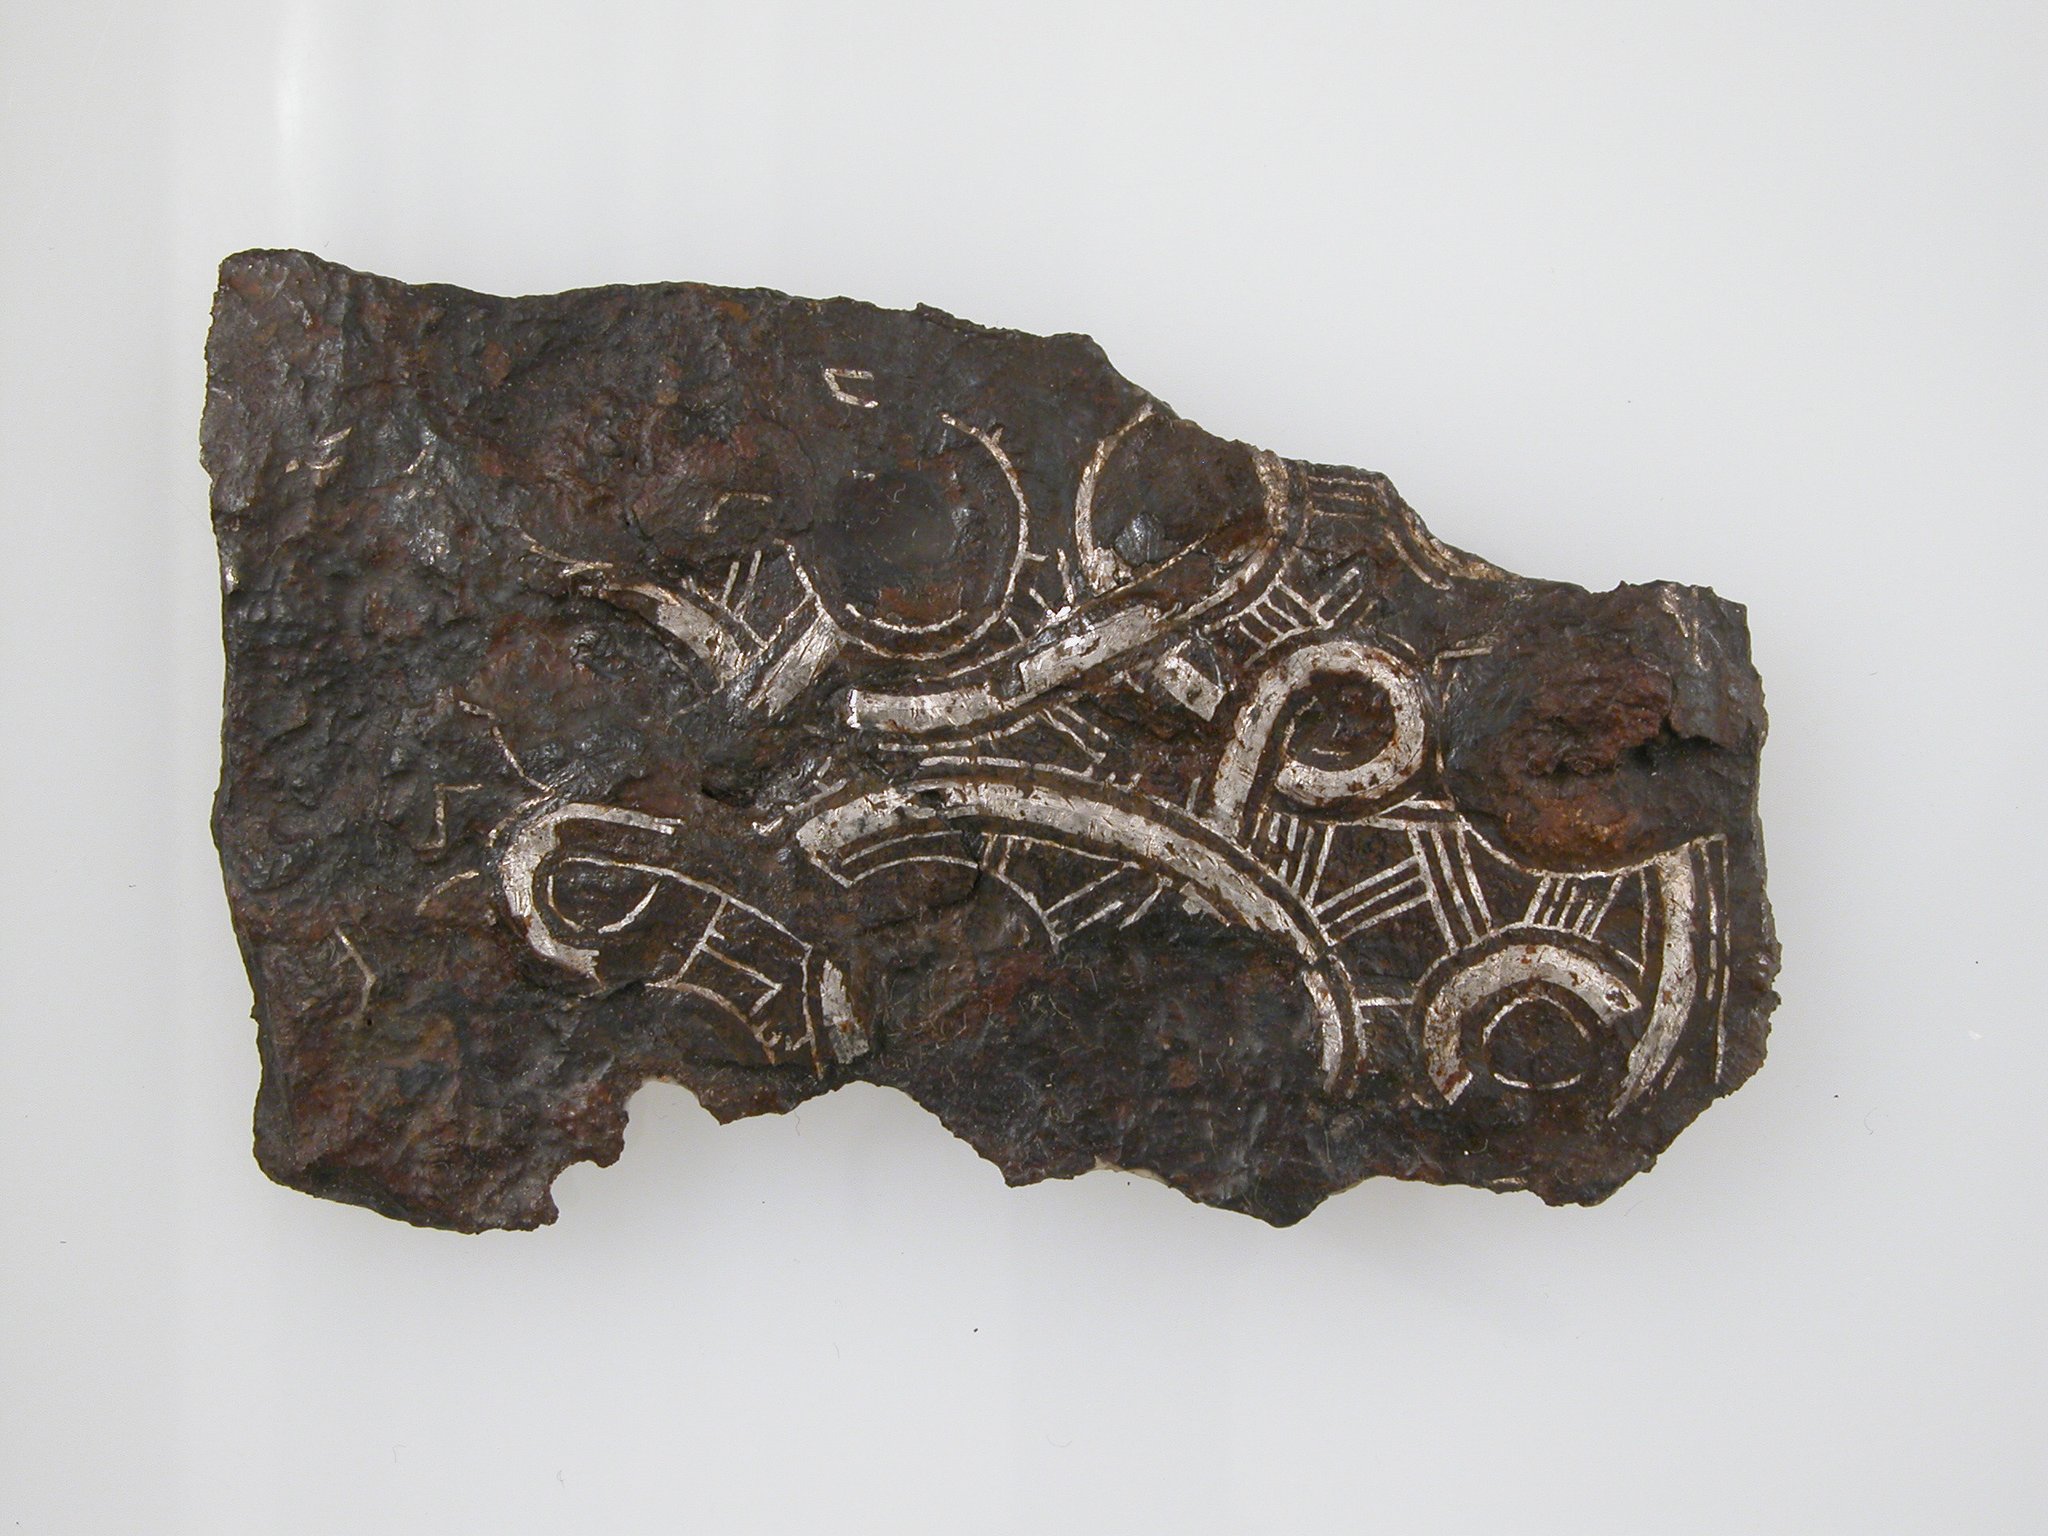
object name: belt plate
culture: frankish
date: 301-700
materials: brass, iron, silver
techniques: inlay